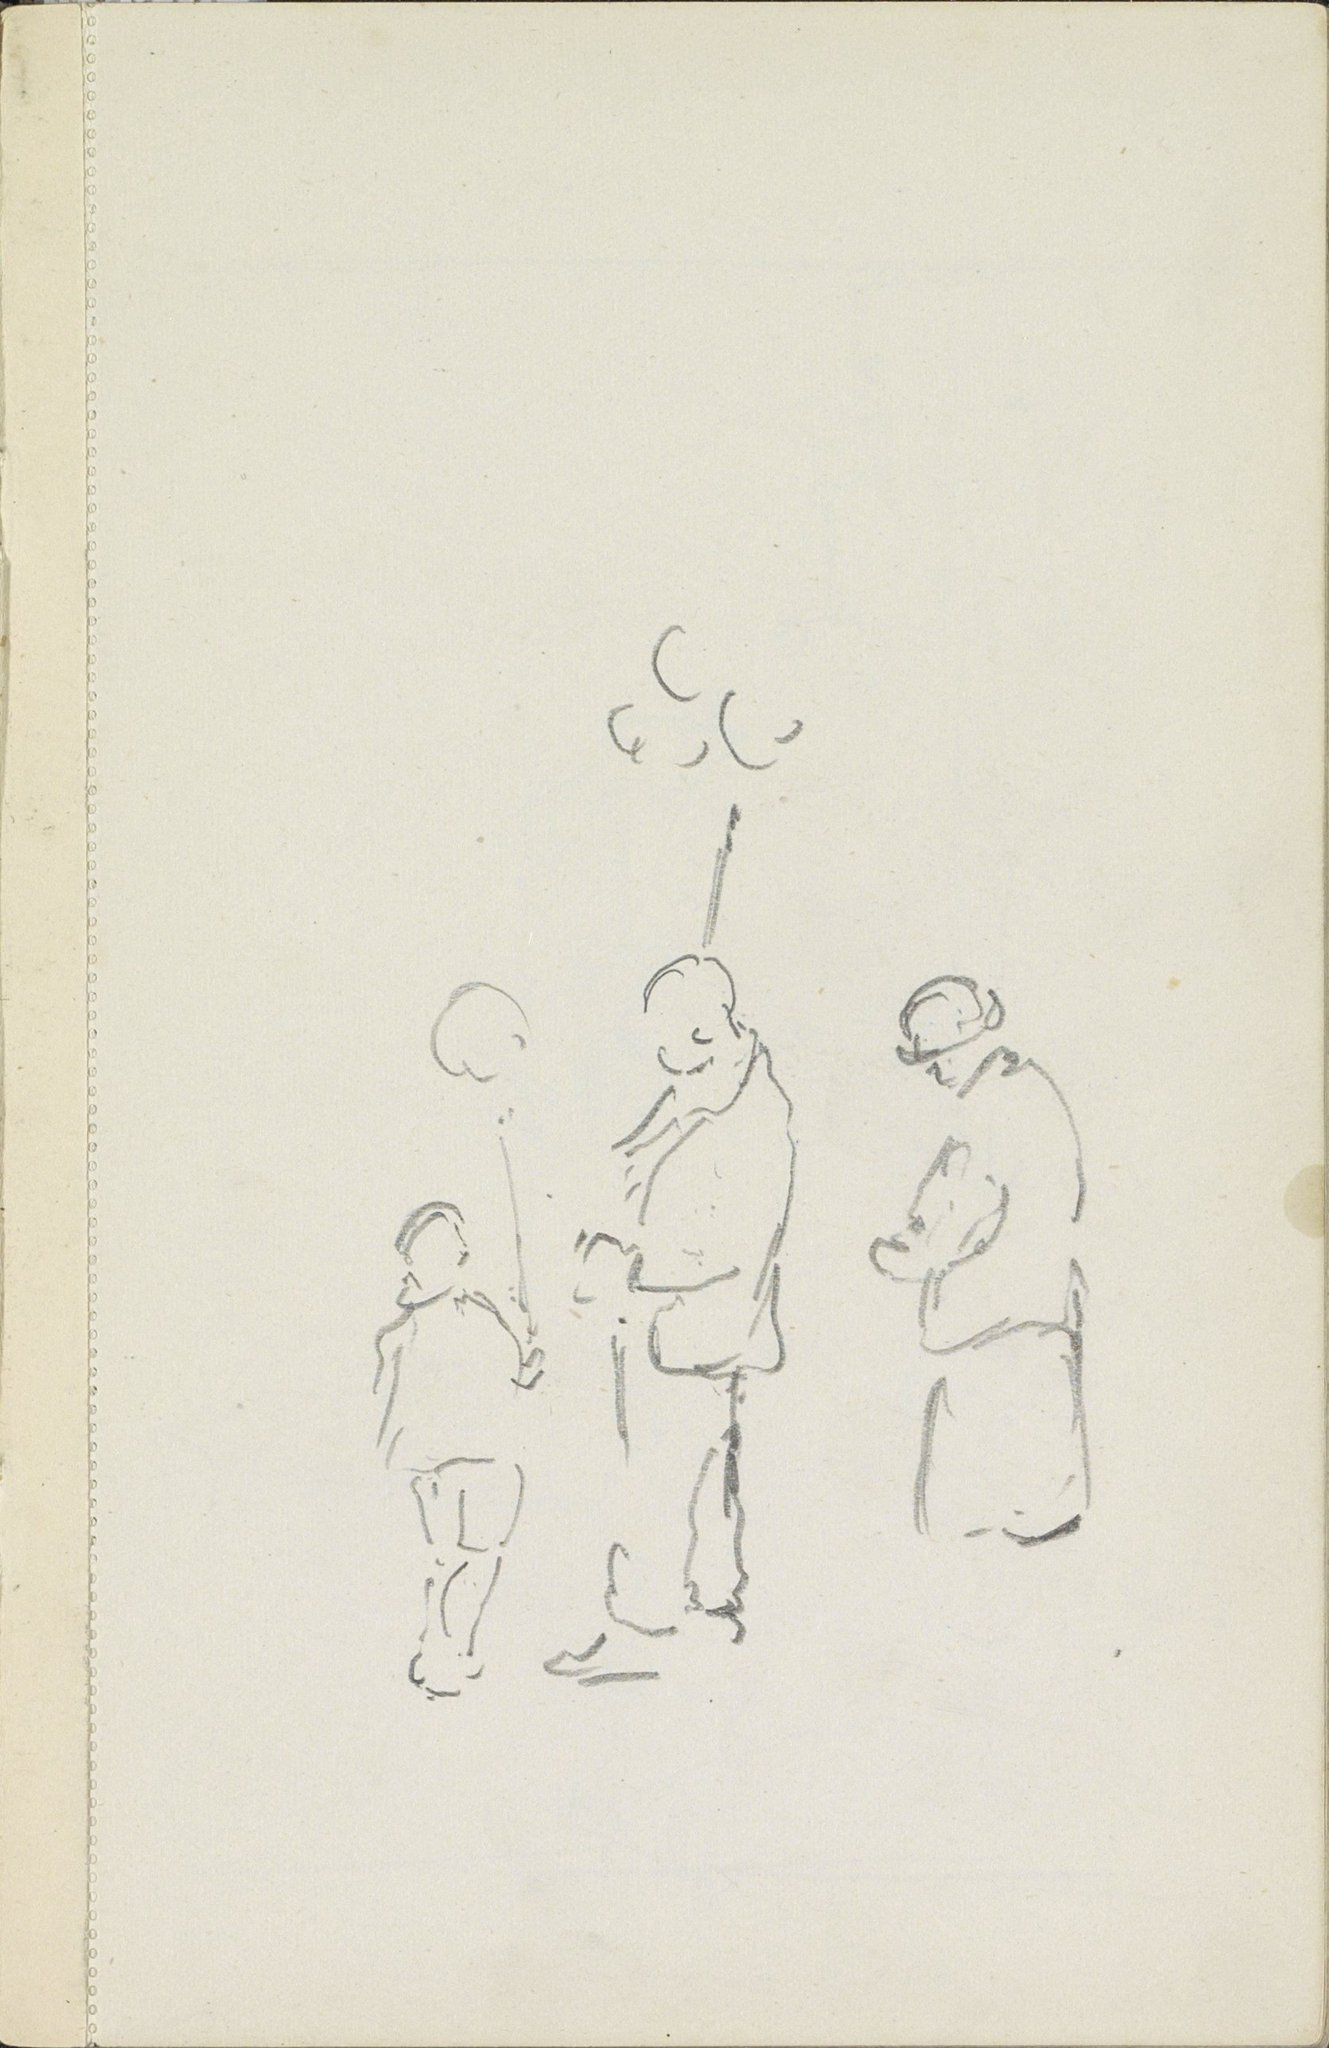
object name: sketchbook leaf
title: Twee figuren en een kind met ballonnen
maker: cornelis vreedenburgh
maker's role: draughtsman, print maker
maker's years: 1880-1946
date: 1890-1946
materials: paper, pencil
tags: adult man, child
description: Blad 5 recto uit een schetsboek met 50 bladen.